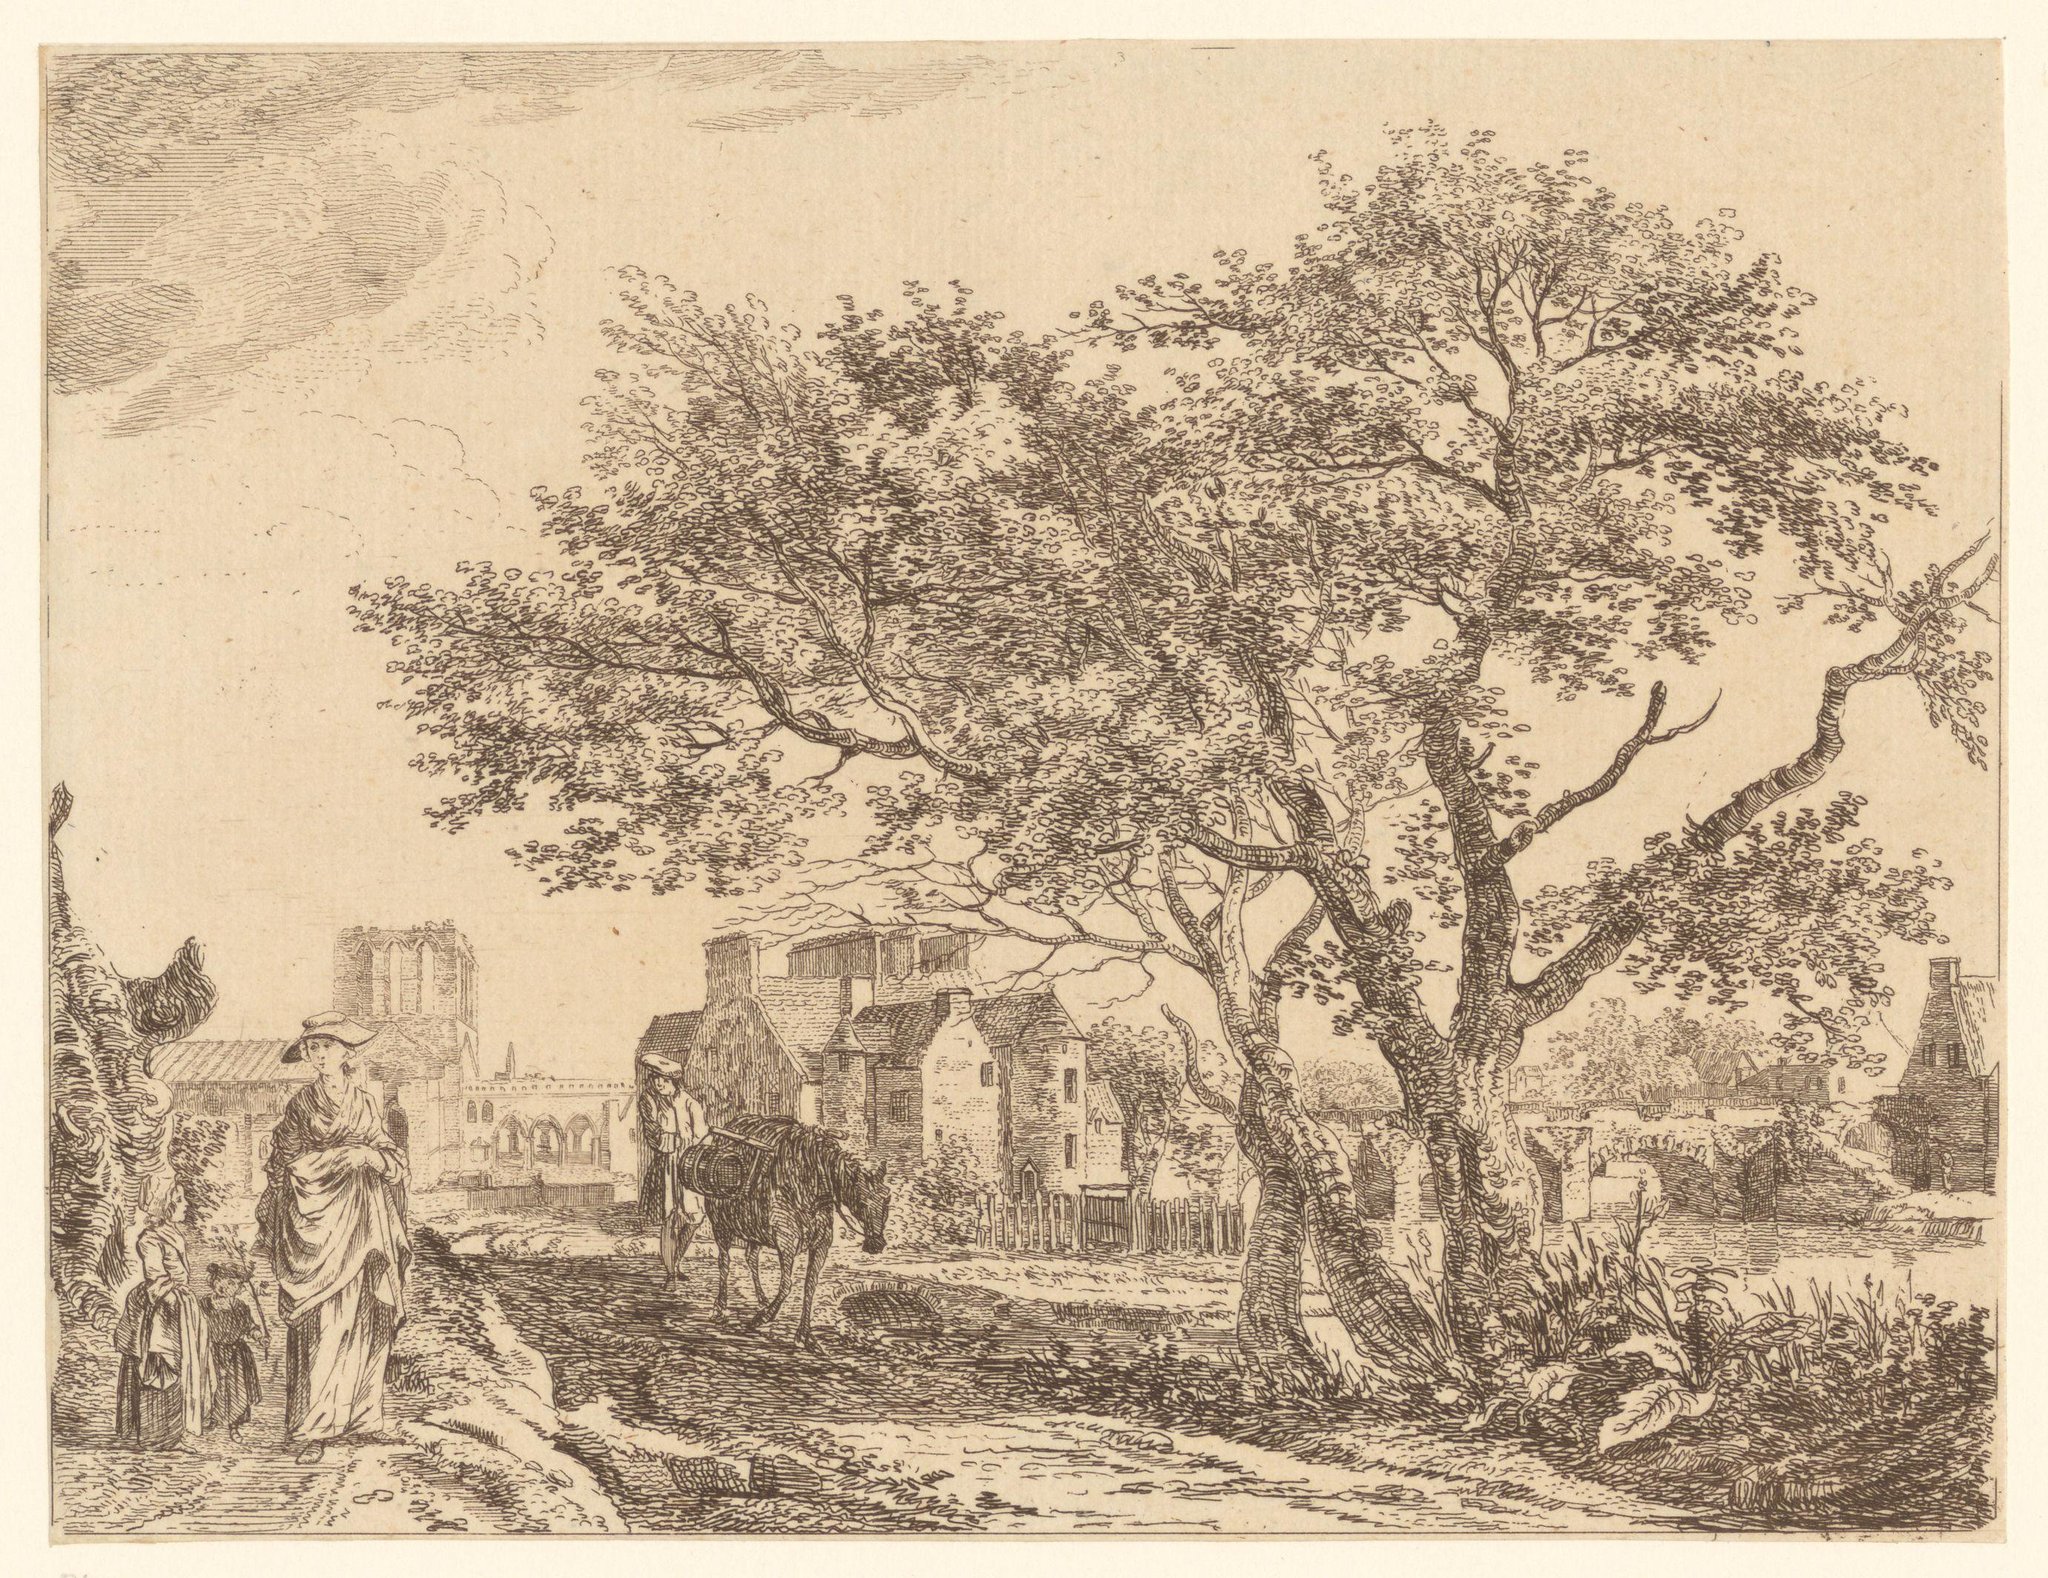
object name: print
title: Schotse landschappen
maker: paul sandby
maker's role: draughtsman, print maker, publisher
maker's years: 1725-1809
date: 1750-1751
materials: paper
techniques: etching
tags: river bank, public road (+ city(-scape) with figures, staffage), prospect of city, town panorama, silhouette of city (+ city(-scape) with figures, staffage)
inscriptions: collector's mark: Lugt 2228